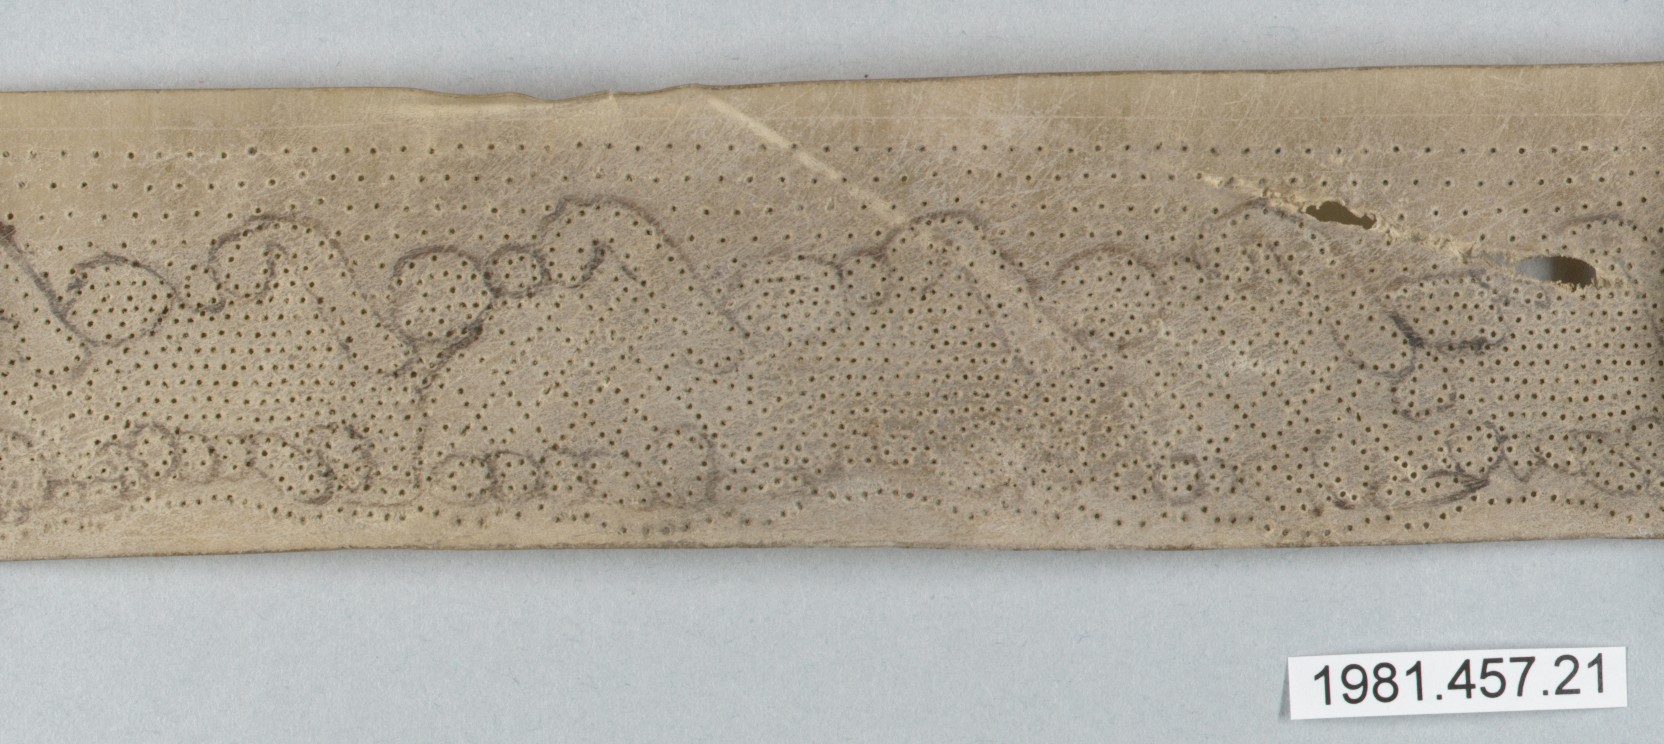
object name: pattern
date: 1840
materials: parchment